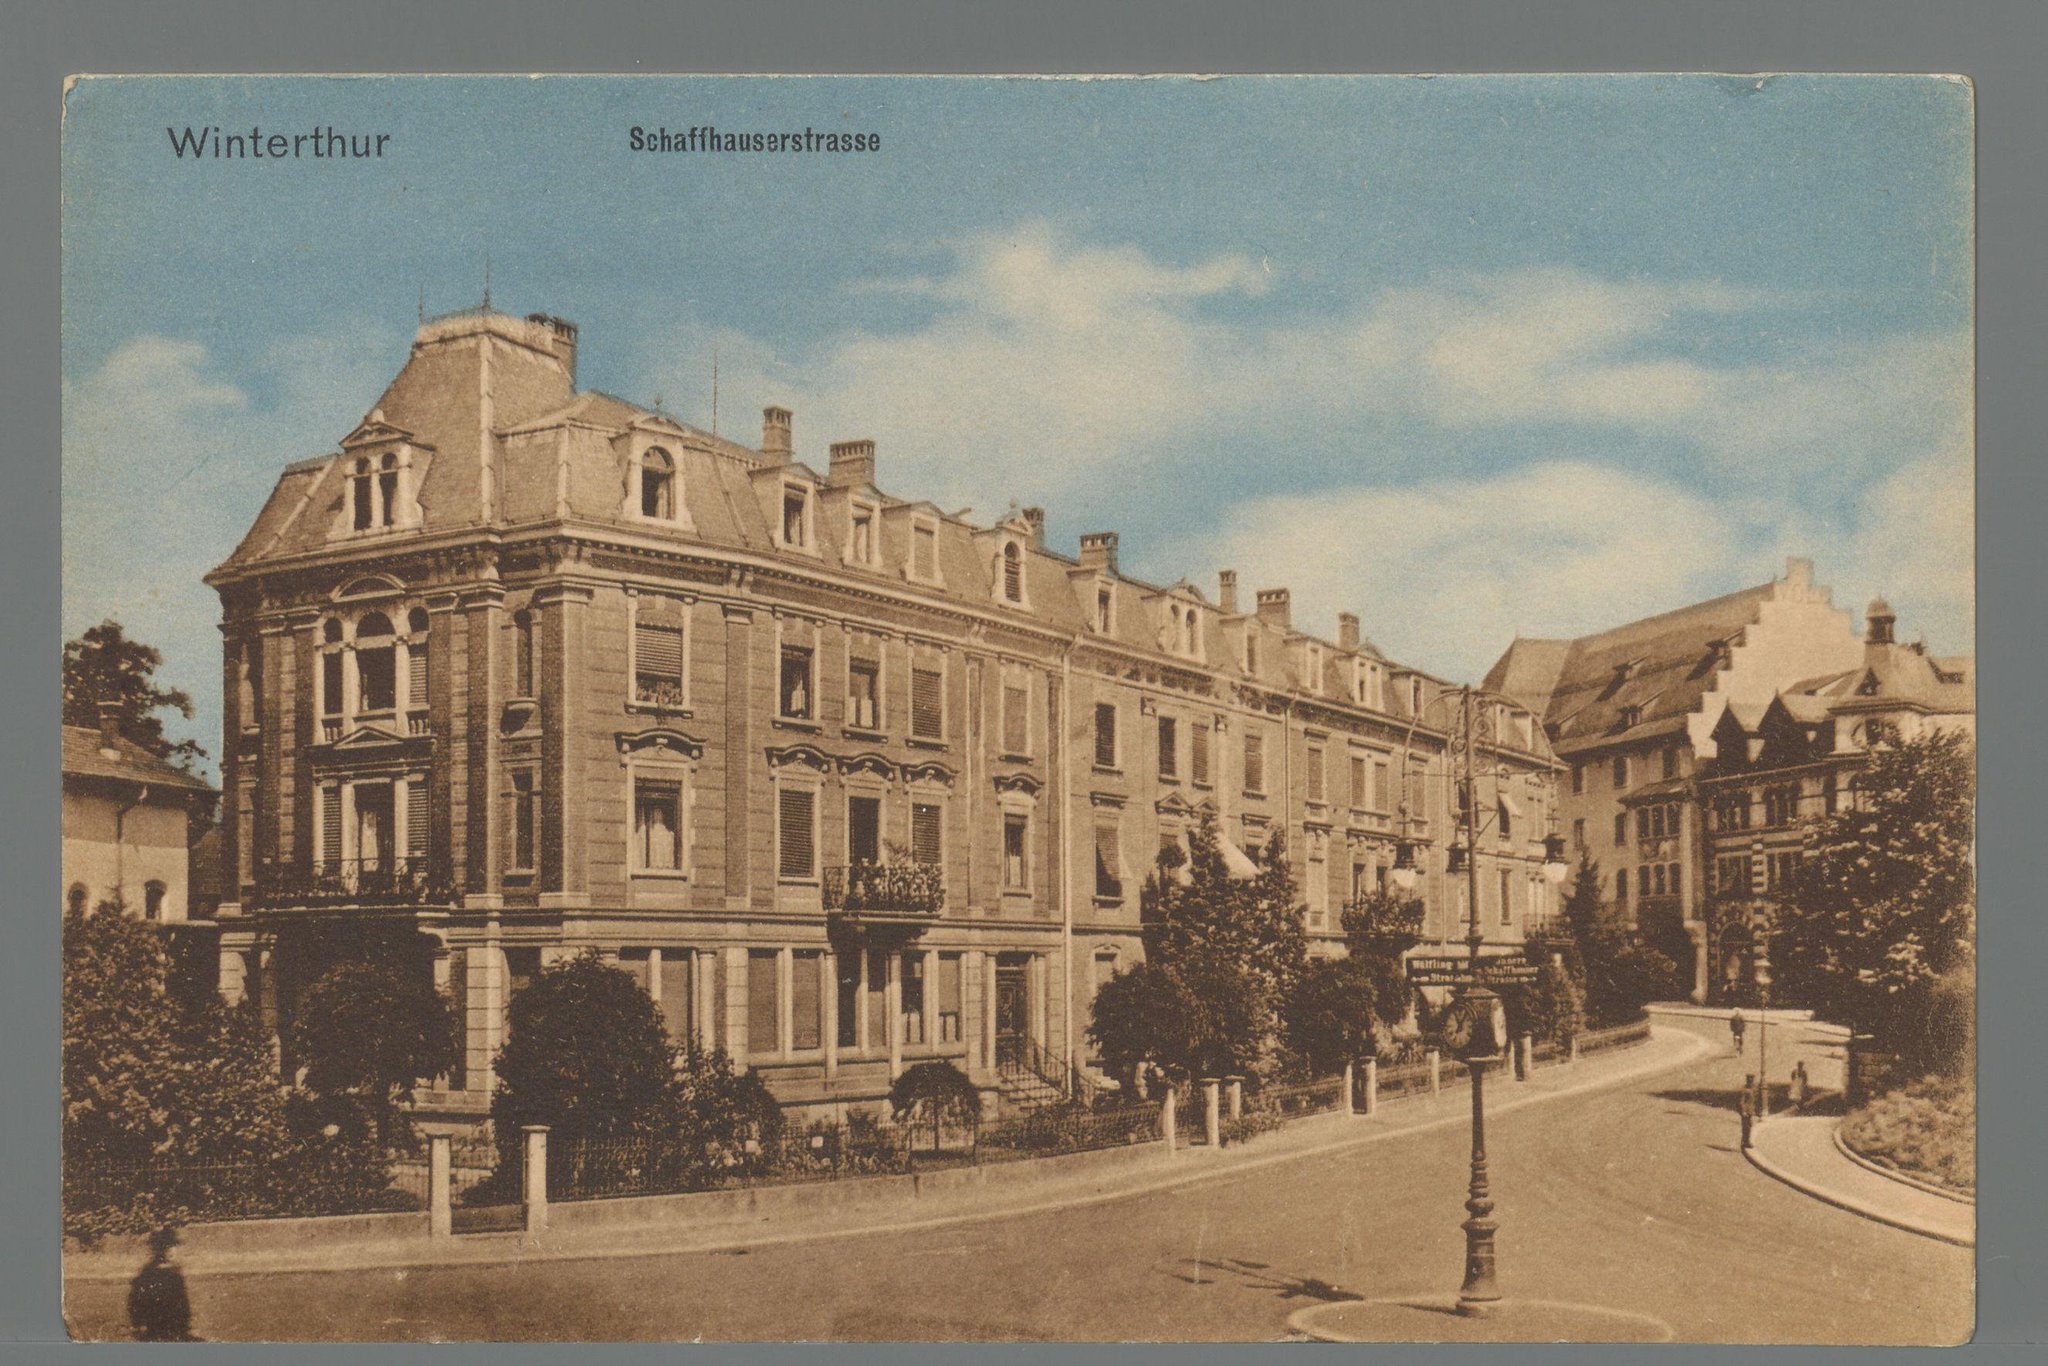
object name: photomechanical print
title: Winterthur. Schaffhauserstrasse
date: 1905-1910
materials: cardboard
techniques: photograph, lithograph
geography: winterthur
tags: the usual house or row of houses, street (+ city(-scape) with figures, staffage)